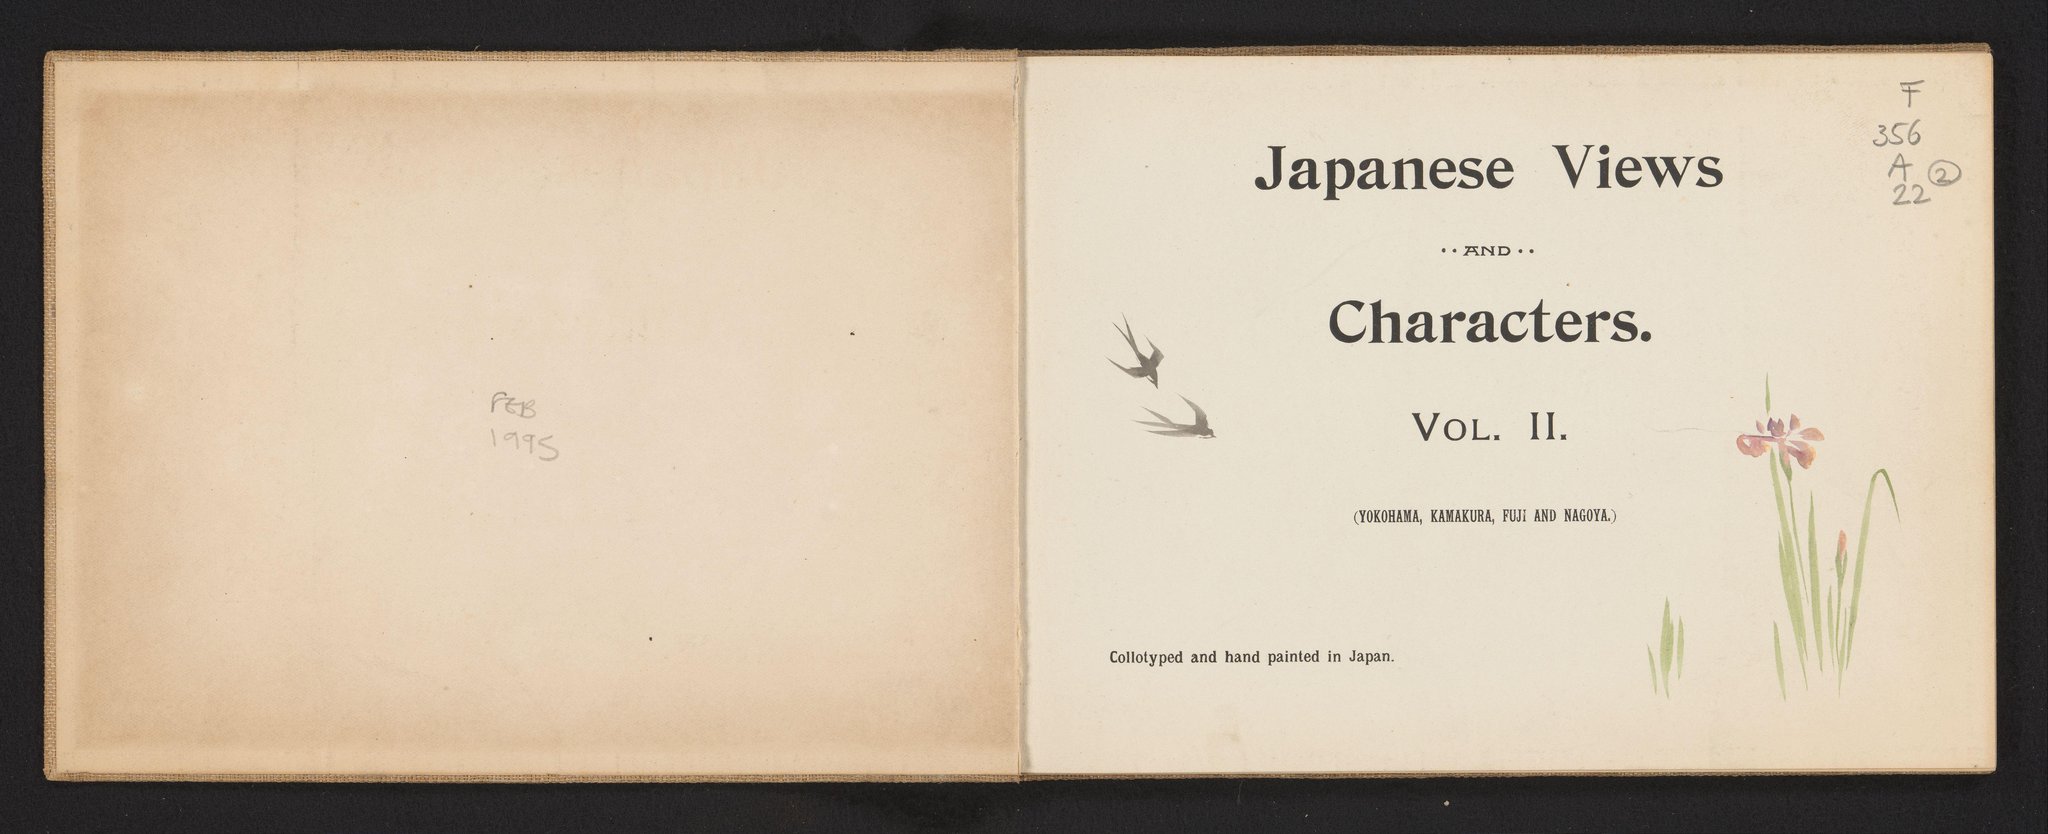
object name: book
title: Japanese views and characters Vol. II.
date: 1905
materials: linen, paint, paper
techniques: photograph, hand coloring